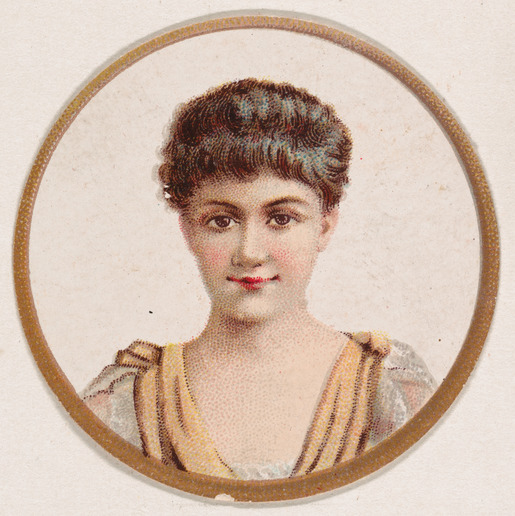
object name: print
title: Portrait of woman, from the Novelties series (N228, Type 2) issued by Kinney Bros.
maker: kinney brothers tobacco company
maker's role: publisher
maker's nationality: american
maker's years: 1869-2011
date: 1889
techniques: color lithograph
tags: portraits,women